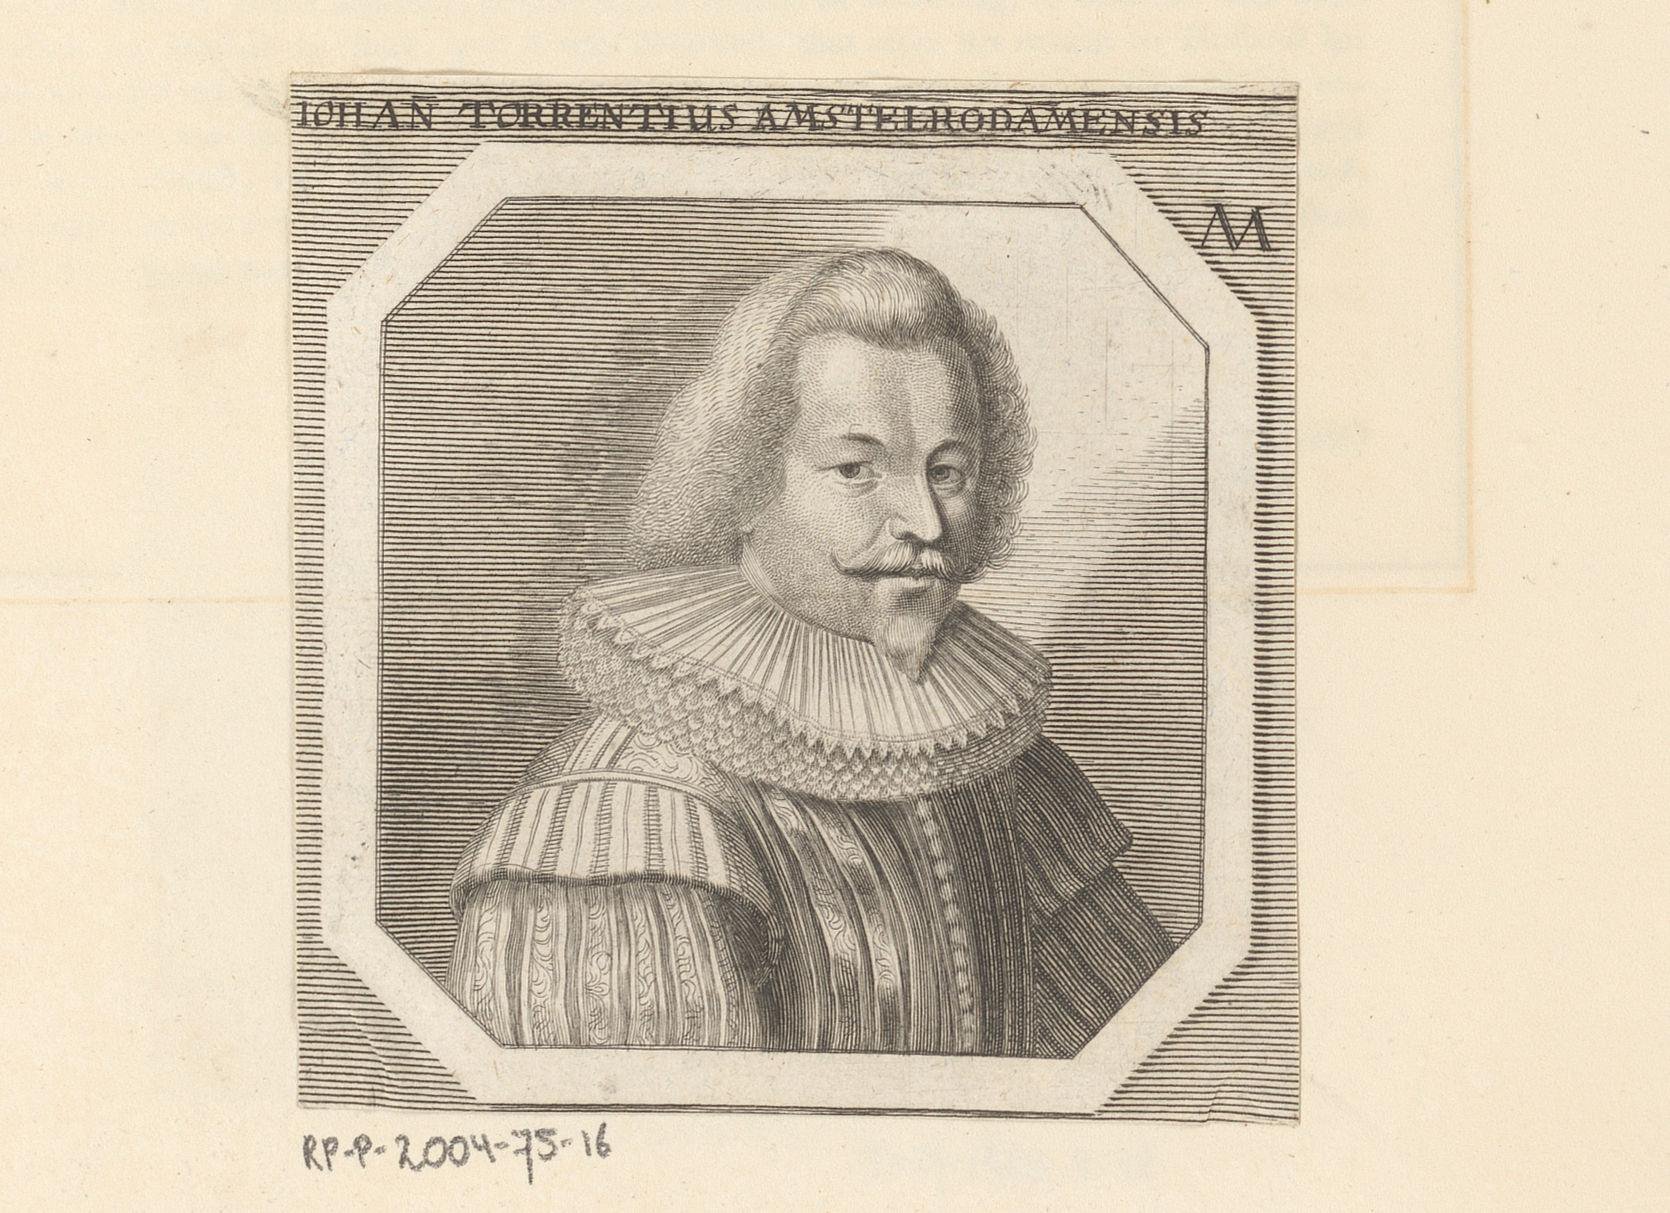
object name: print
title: Portret van Johannes Torrentius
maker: georg andreas wolfgang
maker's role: goldsmith, print maker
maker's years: 1631-1716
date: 1768-1775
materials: paper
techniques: engraving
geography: nuremberg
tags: amsterdam, johannes torrentius, historical persons, portrait, self-portrait of painter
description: Prent uit: Sandrart, Joachim von. Teutsche Academie der Bau- Bildhauer- und Maler-Kunst: worinn die Regeln und Lehrsätze dieser Künste gegeben. 14 dln. Neurenberg: erven Johann Andreas Endter, [1774], dl. 7, p. HH. De samensteller heeft deze prent in het album geplakt als illustratie bij: Pilkington, Matthew en Johann Heinrich Füssli. A dictionary of painters, from the revival of the art to the present period. 4 dln. Londen: John Crowder, 1805, dl. 4, p. 565.